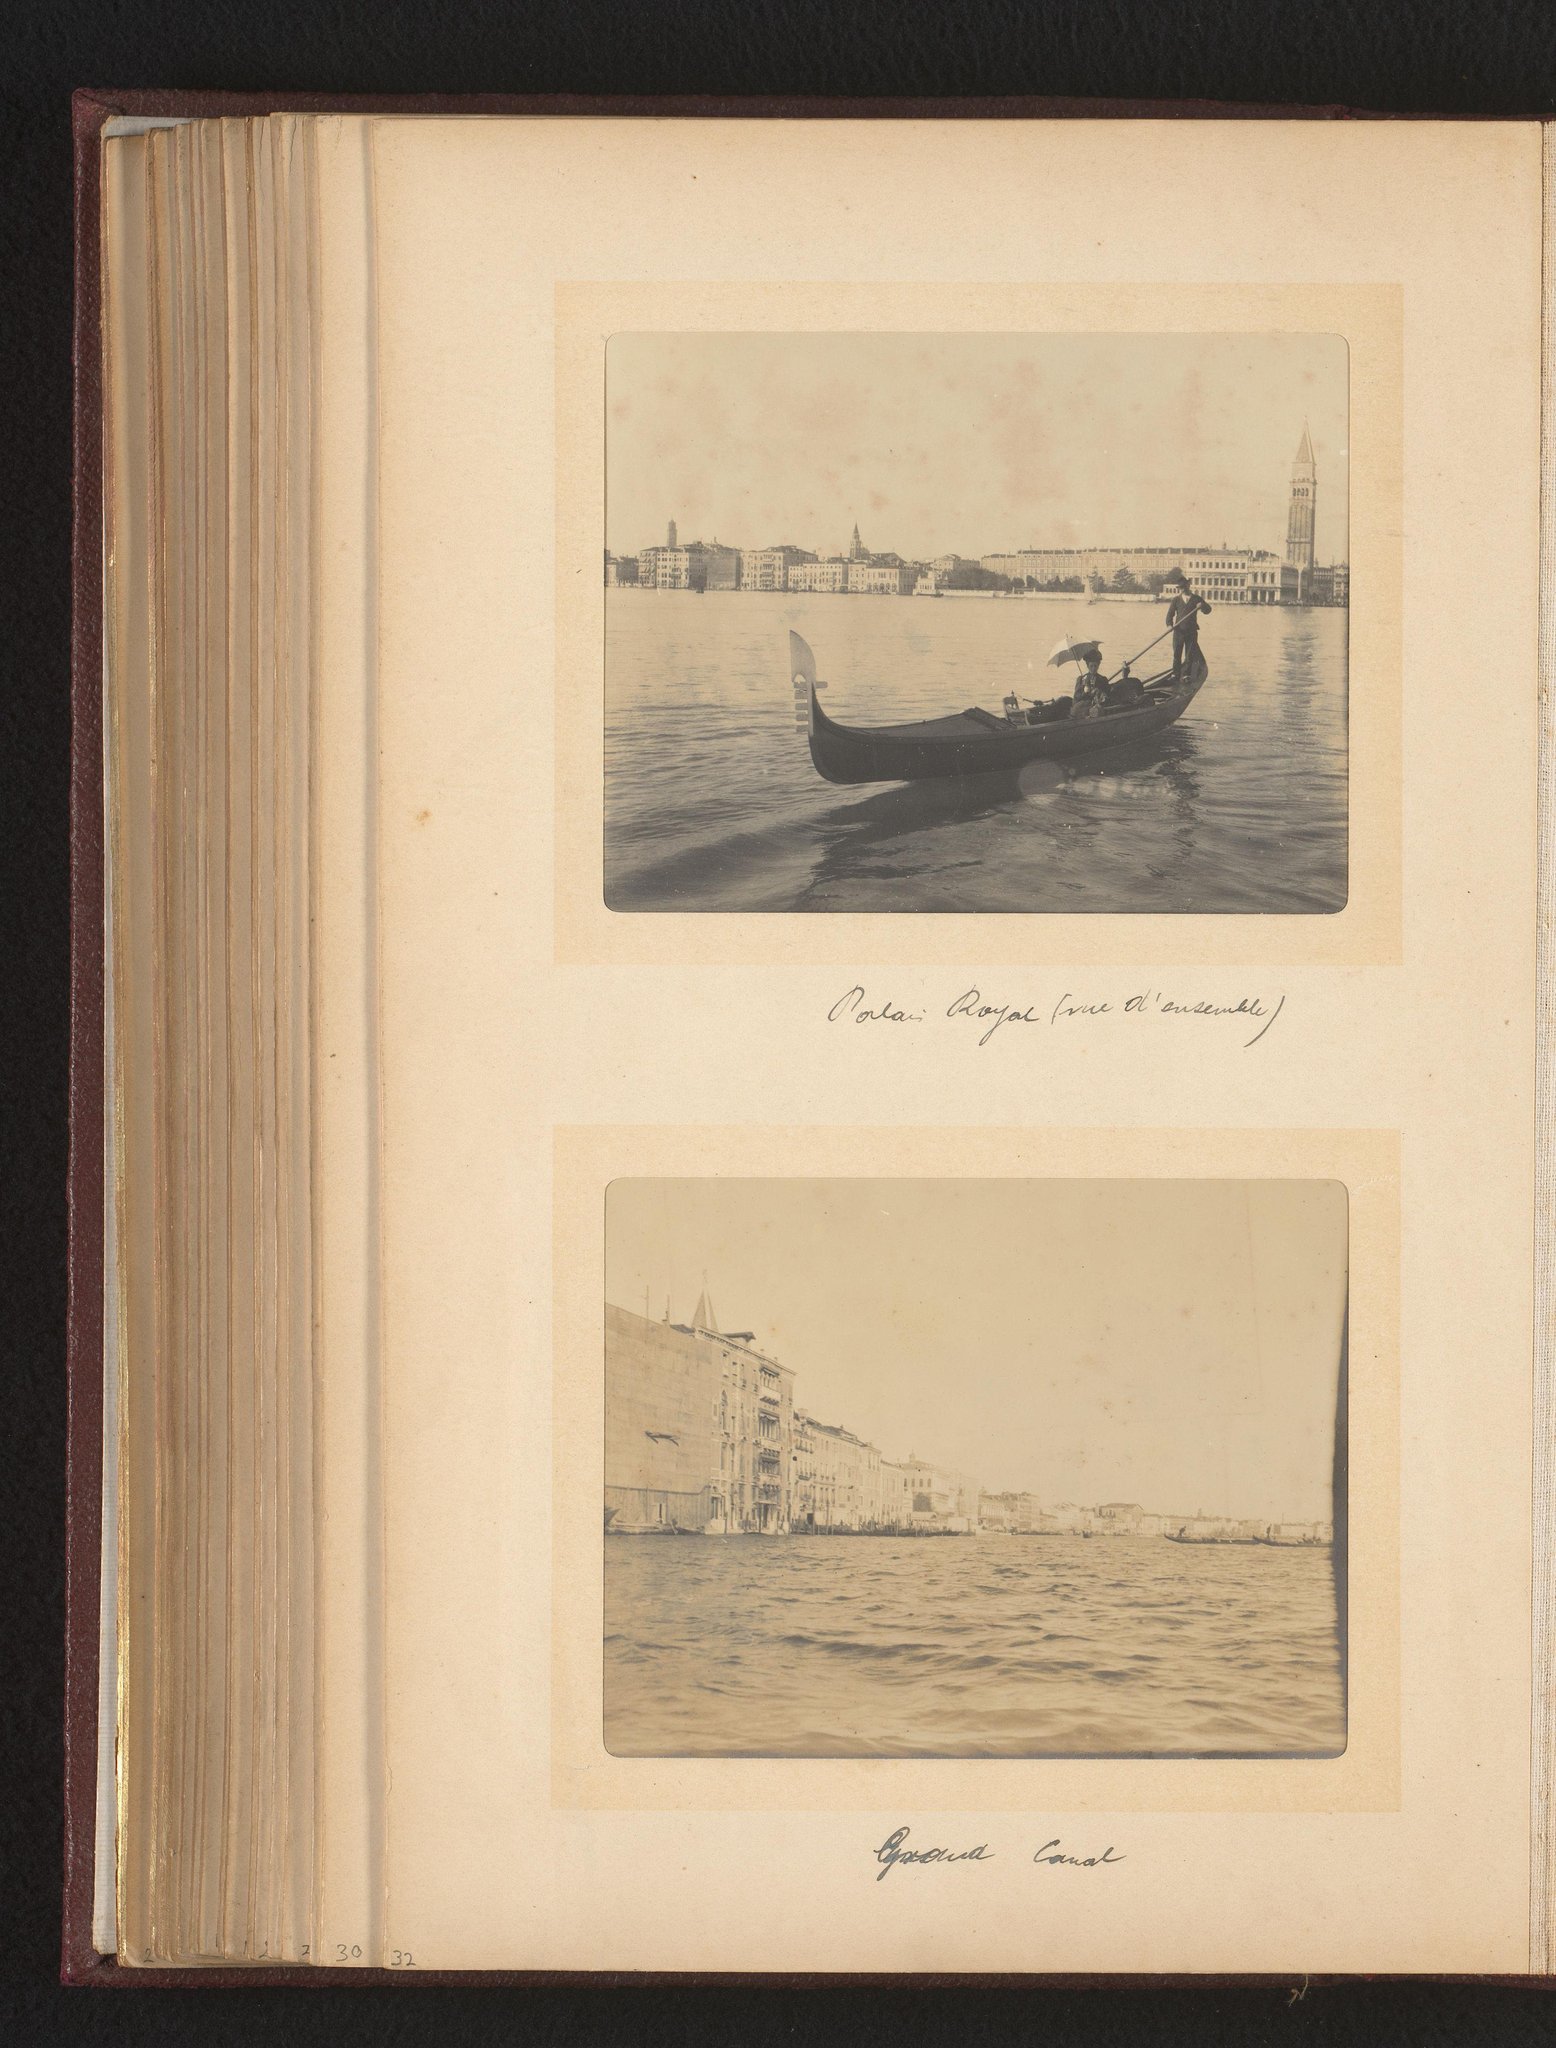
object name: photograph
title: Gondel met stadsprofiel en gezicht vanaf de Canal Grande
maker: Anonymous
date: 1895-1905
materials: cardboard, photographic support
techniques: gelatin silver print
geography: venice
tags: tourism, gondola, canals, waters (in city) (+ city(-scape) with figures, staffage), venice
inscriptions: inscription: ‘Palais Royal (vue d'ensemble) / Grand Canal’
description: Albumblad met twee foto's in Venetië. Onderdeel van een fotoalbum van een reis door Italië, ca. 1900.